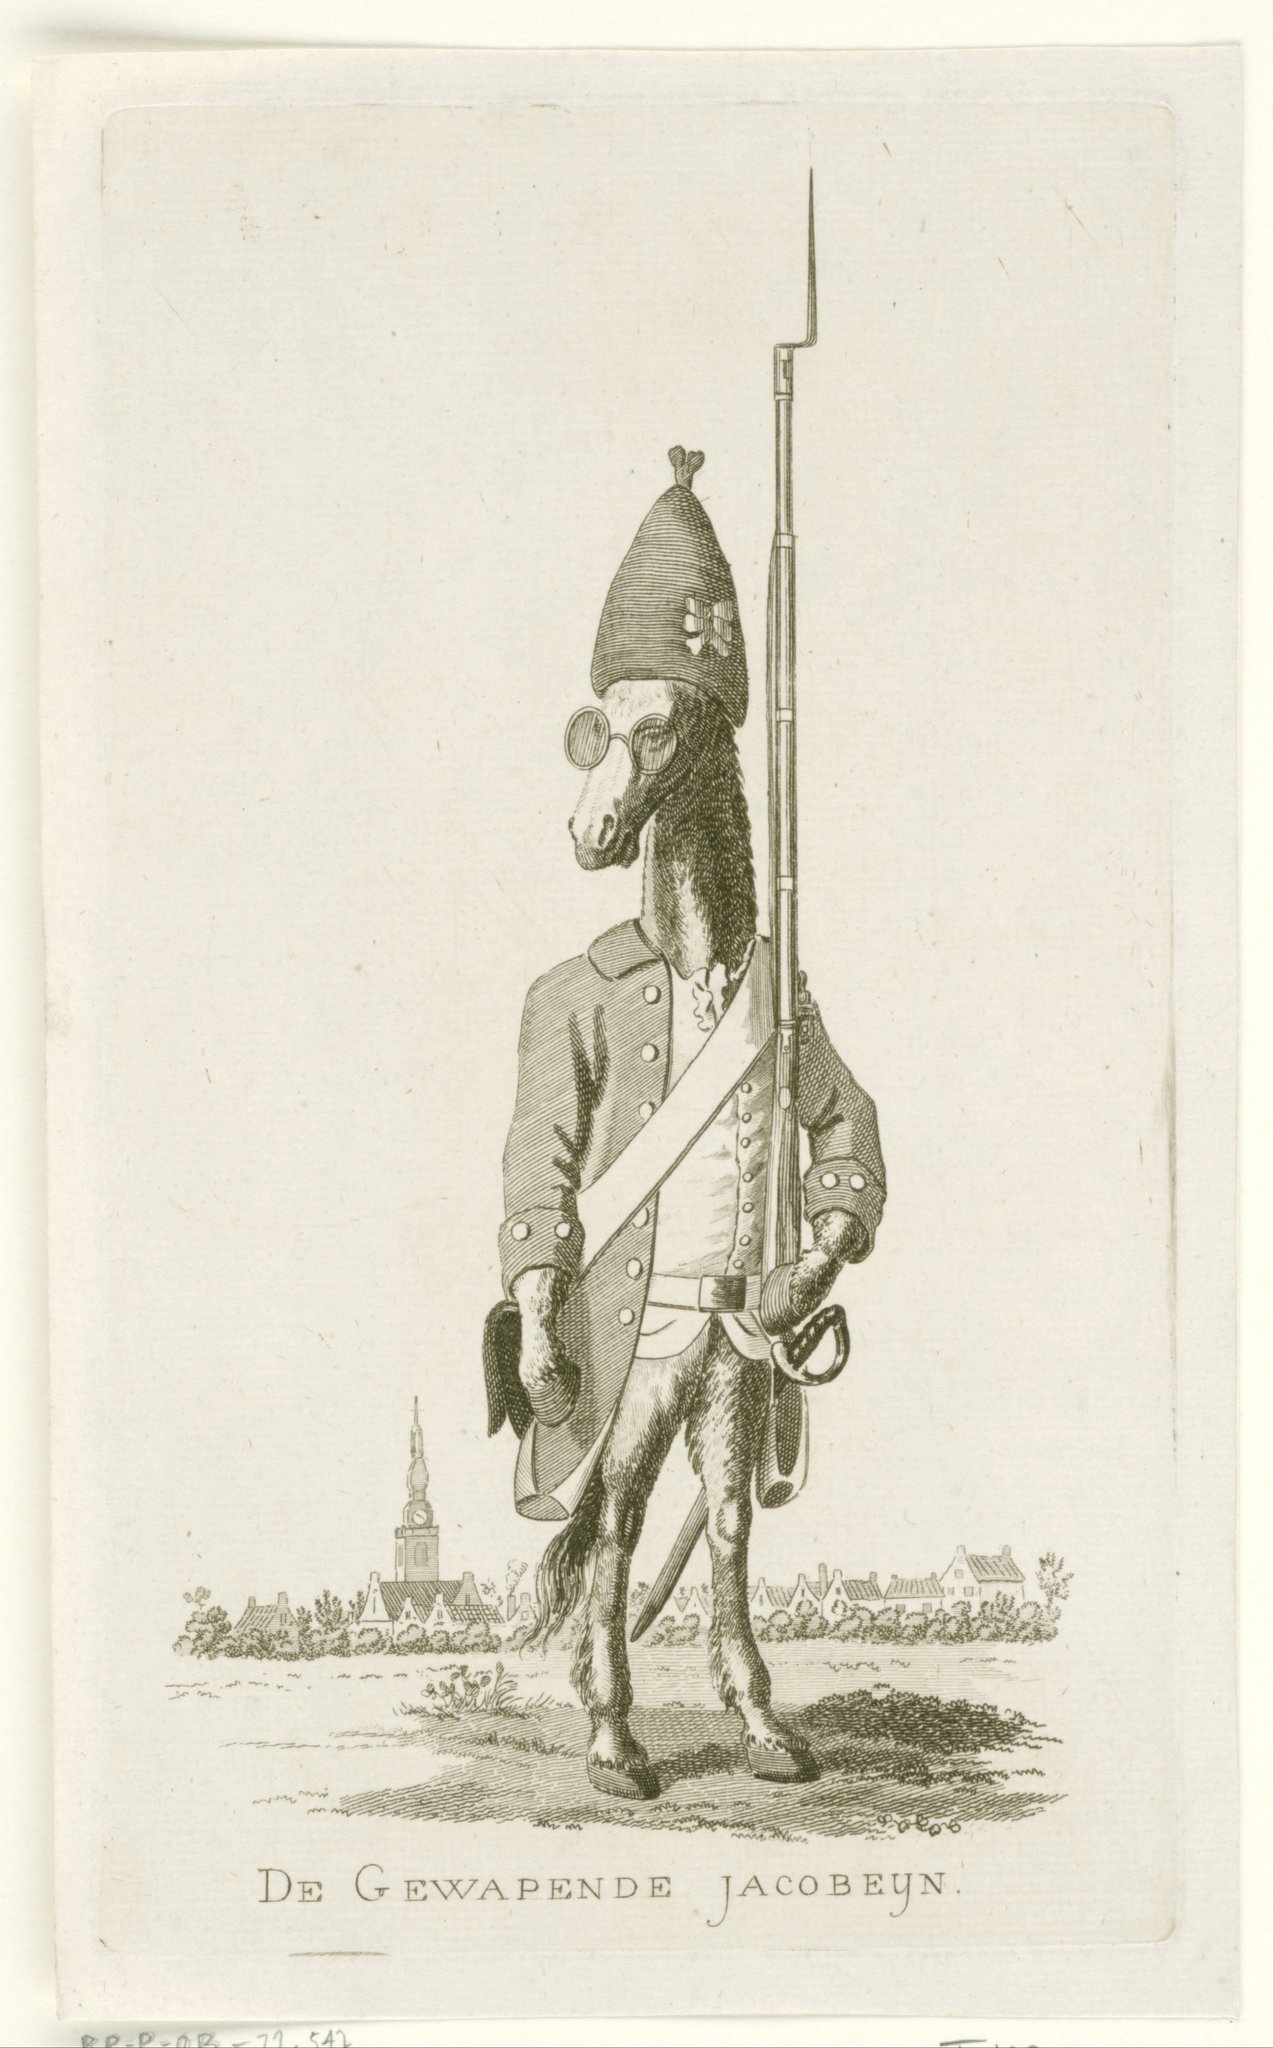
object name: cartoon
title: De Gewapende Jacobeyn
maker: Anonymous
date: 1785-1790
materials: paper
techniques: engraving, etching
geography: northern netherlands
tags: animals acting as human beings, mule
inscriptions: collector's mark: Lugt 2228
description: Spotprent op de Jacobijnen in Frankrijk, 1789-1790. Ezel, staand op zijn achterpoten, gekleed als Frans patriot, met bril op de neus, hoge muts en kokarde, geweer over de schouder. Op de achtergrond een kleine stad.